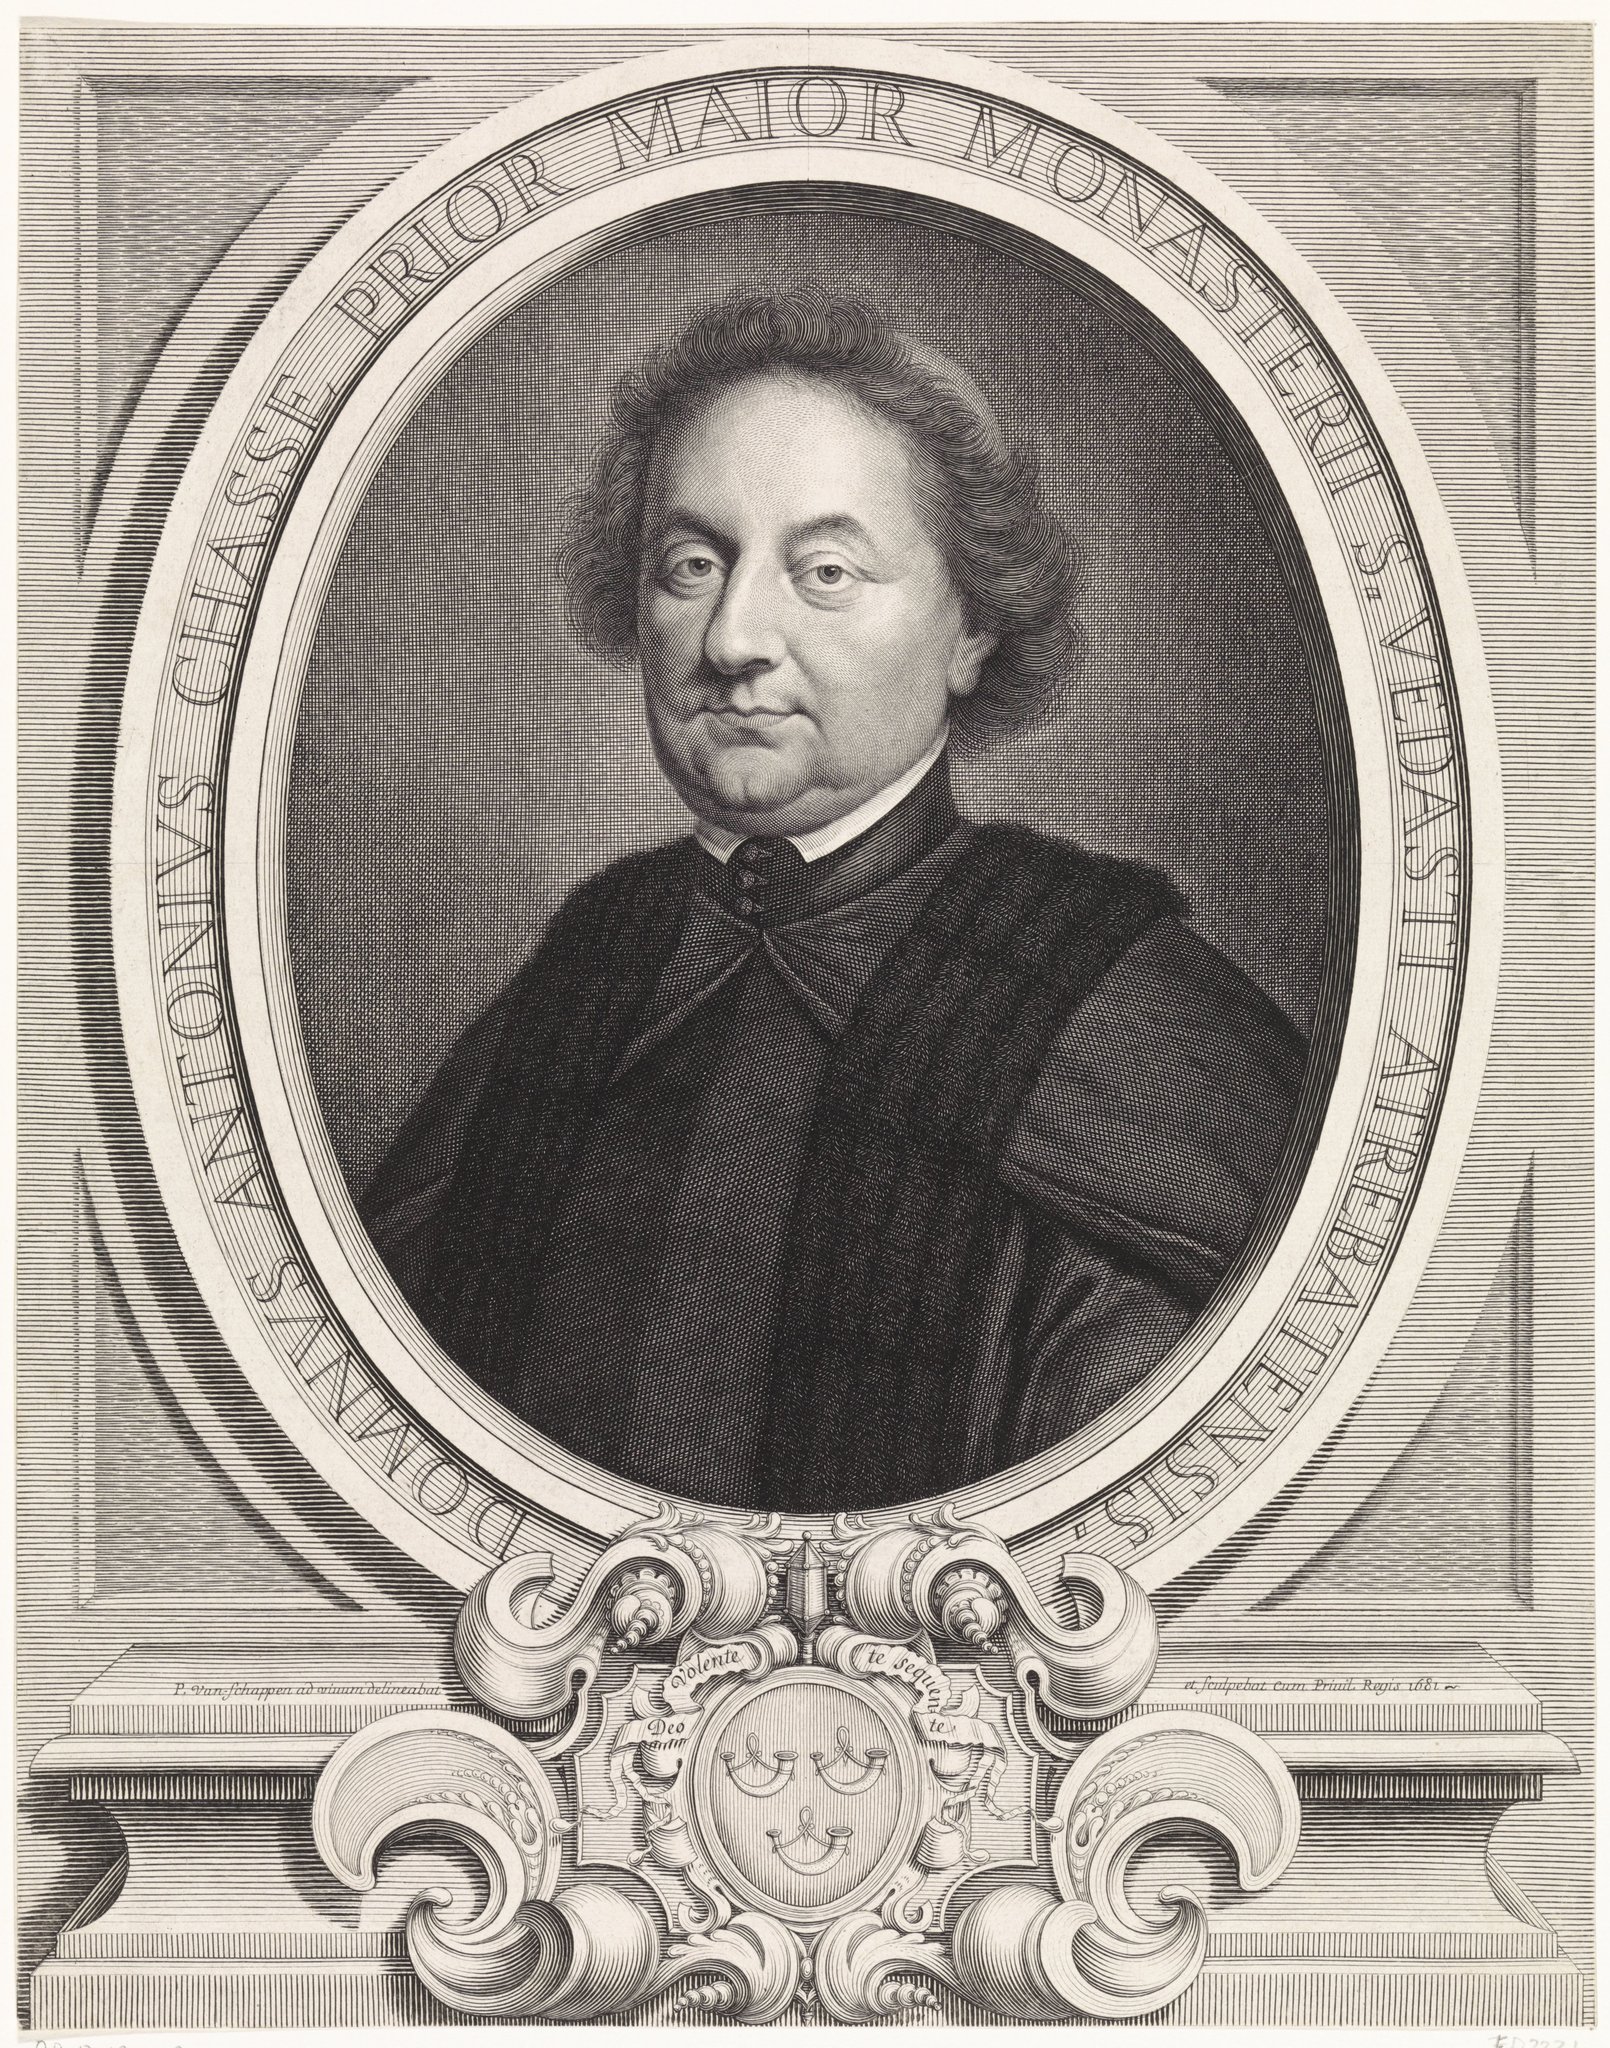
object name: print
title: Portret van Antoine de Chasse, grootprior van de abdij van St, Vaast in Arras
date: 1681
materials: paper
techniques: engraving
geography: paris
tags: prior, antoine de chasse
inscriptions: collector's mark: Lugt 2228